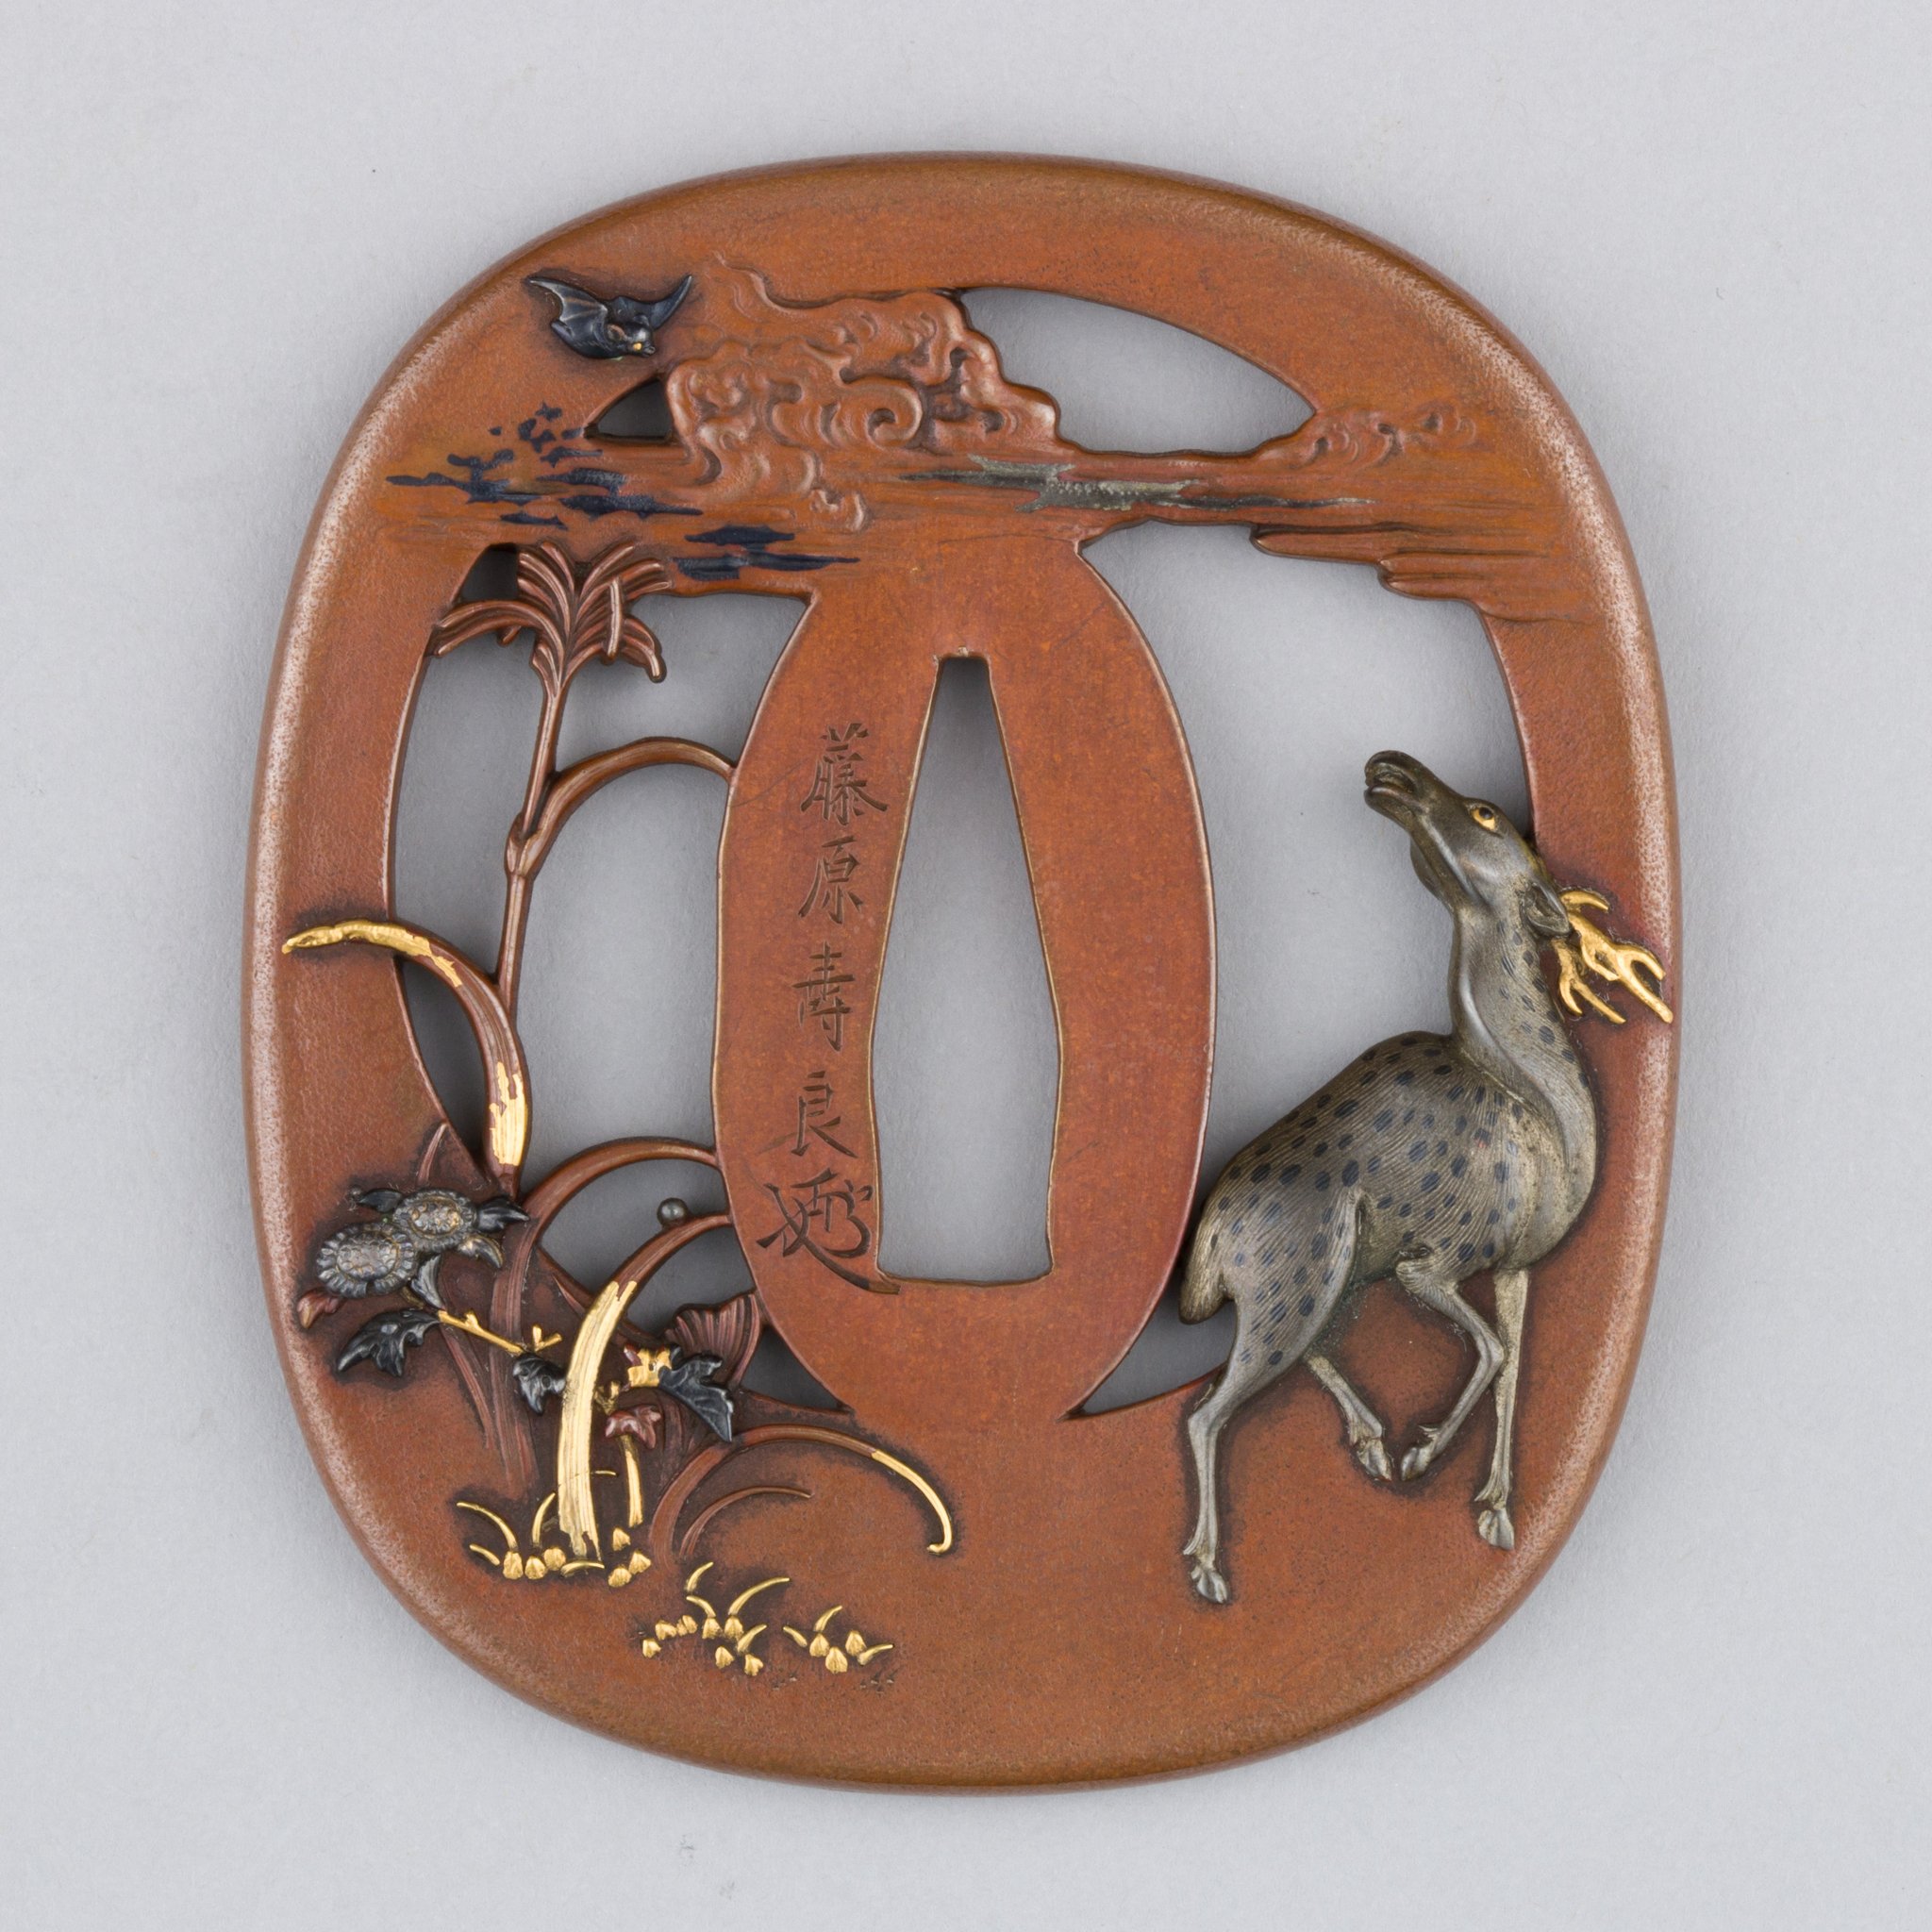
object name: 秋草に鹿図鐔 sword guard i tsuba i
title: 秋草に鹿図鐔 Sword Guard (Tsuba)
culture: japanese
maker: 紫原壽良画 murasakibara toshiyoshi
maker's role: fittings maker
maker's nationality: japanese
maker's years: 1865-1884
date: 1801-1900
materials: copper, gold alloy, silver alloy, gold, silver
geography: japan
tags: bats,deer